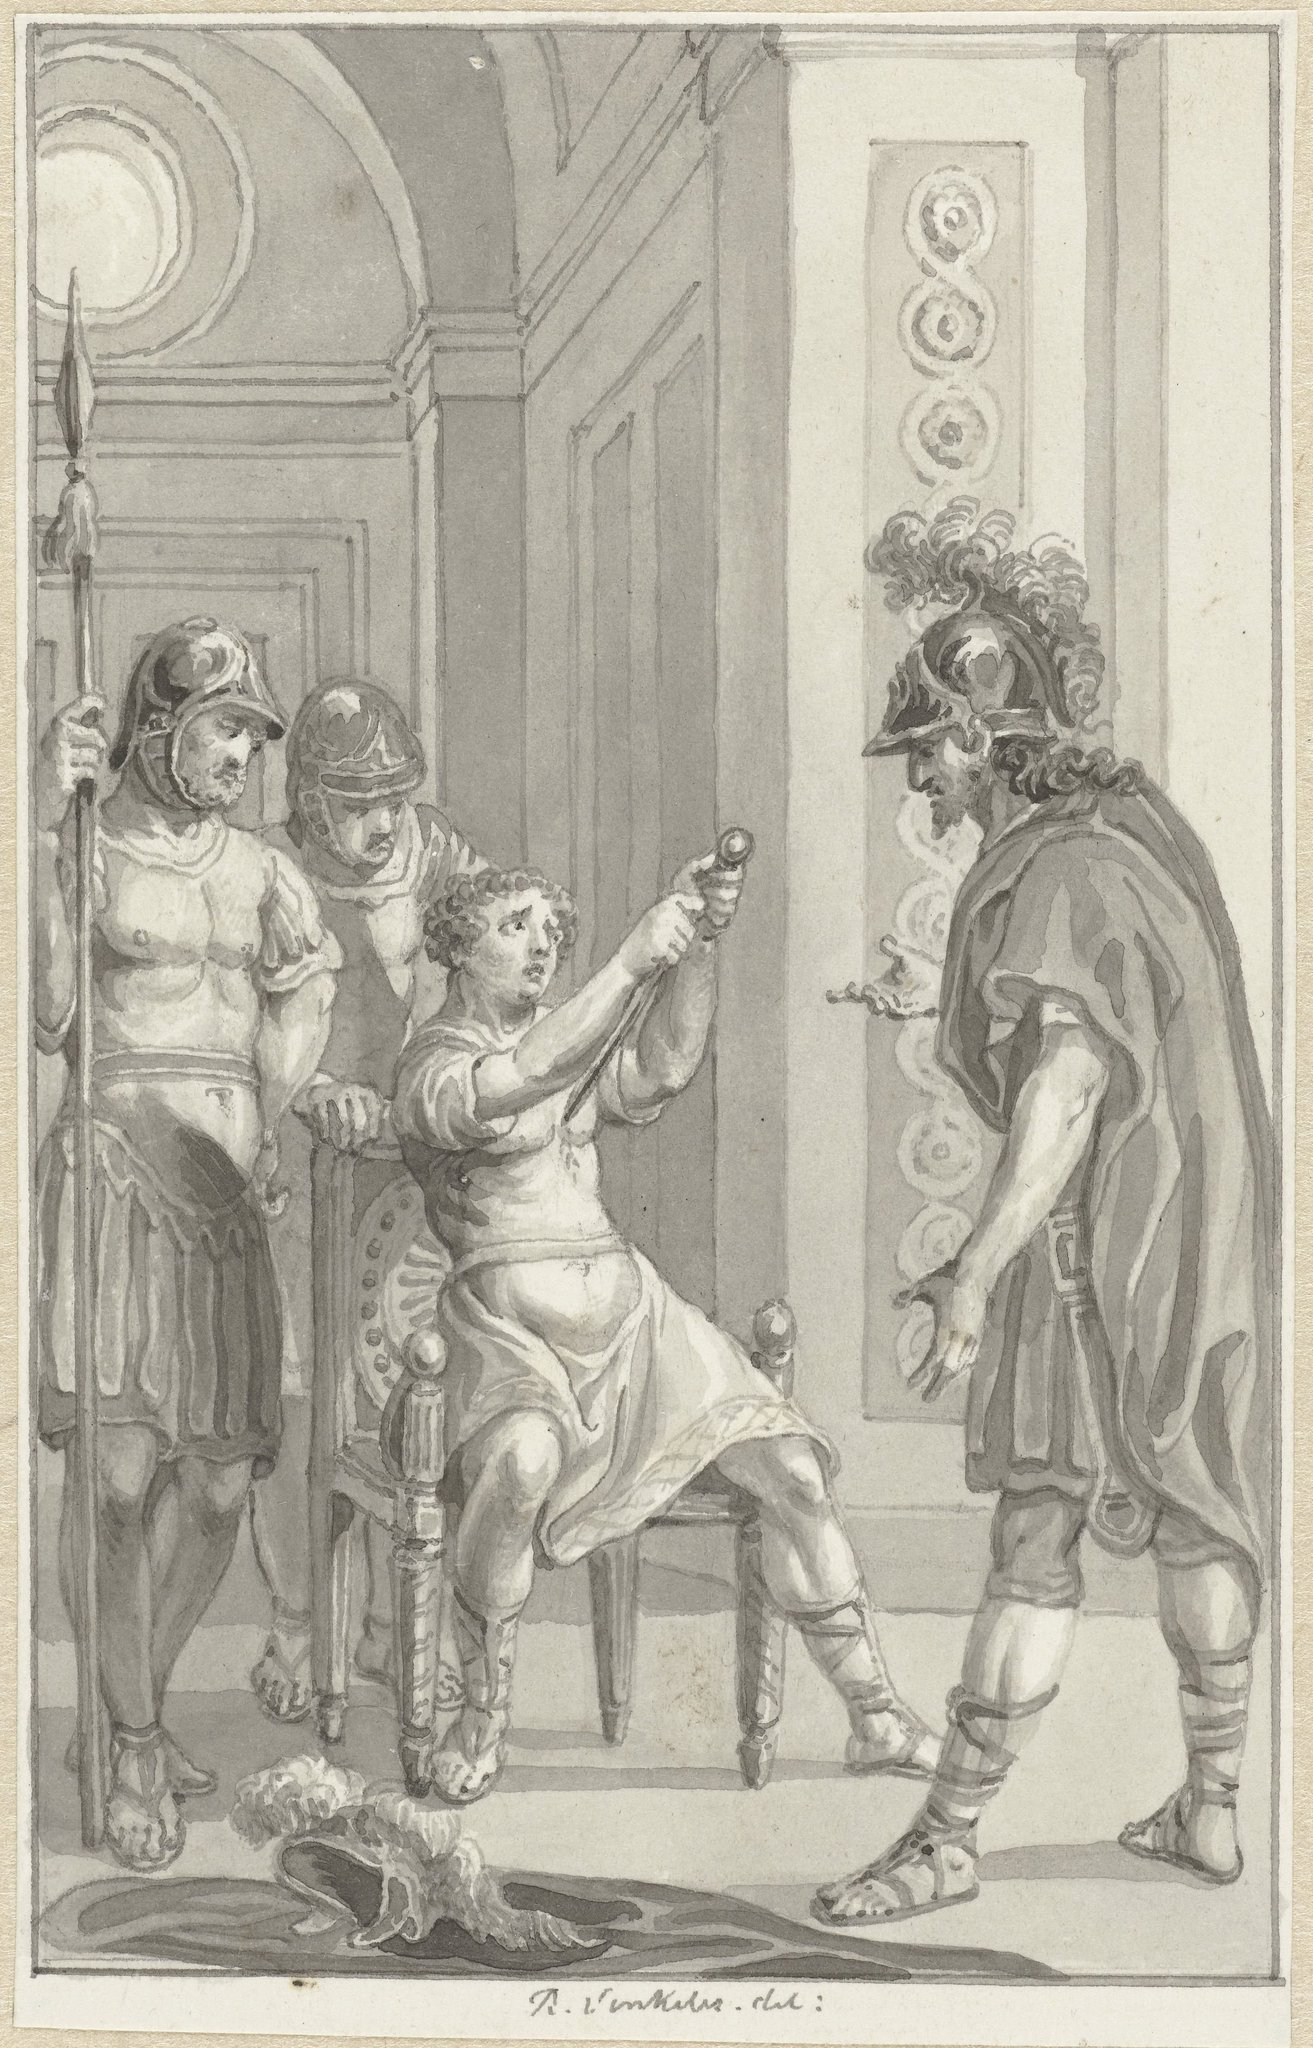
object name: drawing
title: De dood van Gemellus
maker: reinier vinkeles (i)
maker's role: draughtsman, print maker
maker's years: 1741-1816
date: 1804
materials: ink, paper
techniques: brush, pen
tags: male persons from classical history (gemellus) - death of person from classical history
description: Ontwerp voor gravure door Ludwig Portman in M. Stuart's `Romeinsche Geschiedenissen', 1804; dl. 23, t.o. p. 24.